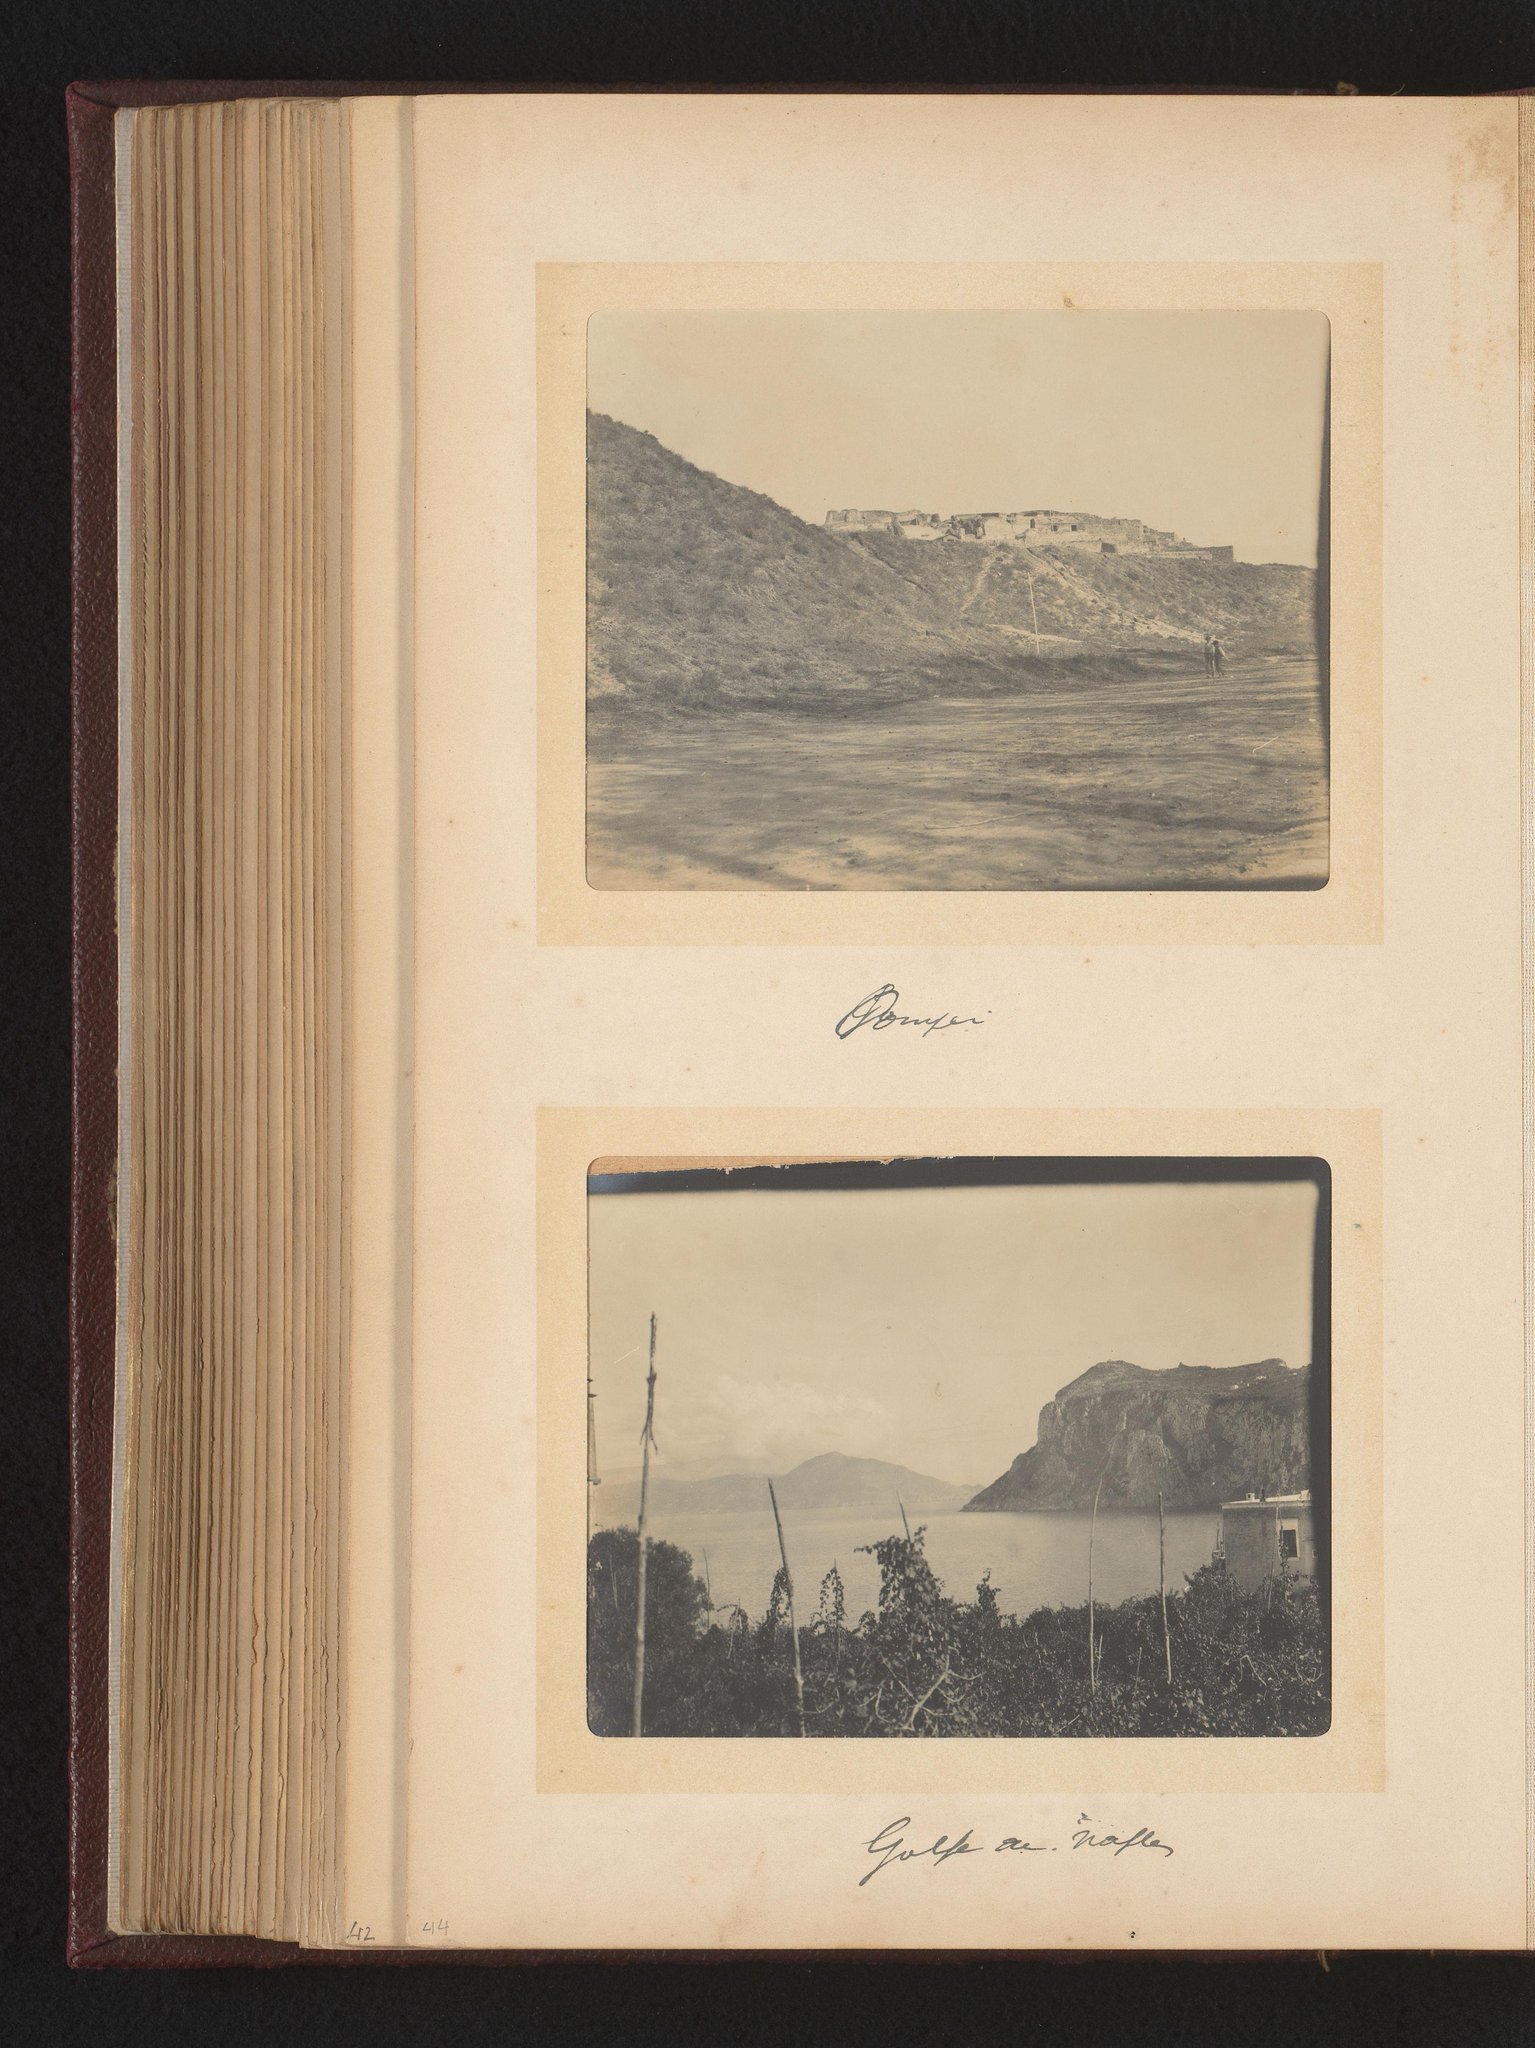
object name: photograph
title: Pompeï en Golf van Napels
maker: Anonymous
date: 1895-1905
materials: cardboard, photographic support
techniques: gelatin silver print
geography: naples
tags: tourism, landscape with ruins, naples, pompeii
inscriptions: inscription: ‘Pompei / Golfe de Naples’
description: Albumblad met twee foto's in Napels. Onderdeel van een fotoalbum van een reis door Italië, ca. 1900.